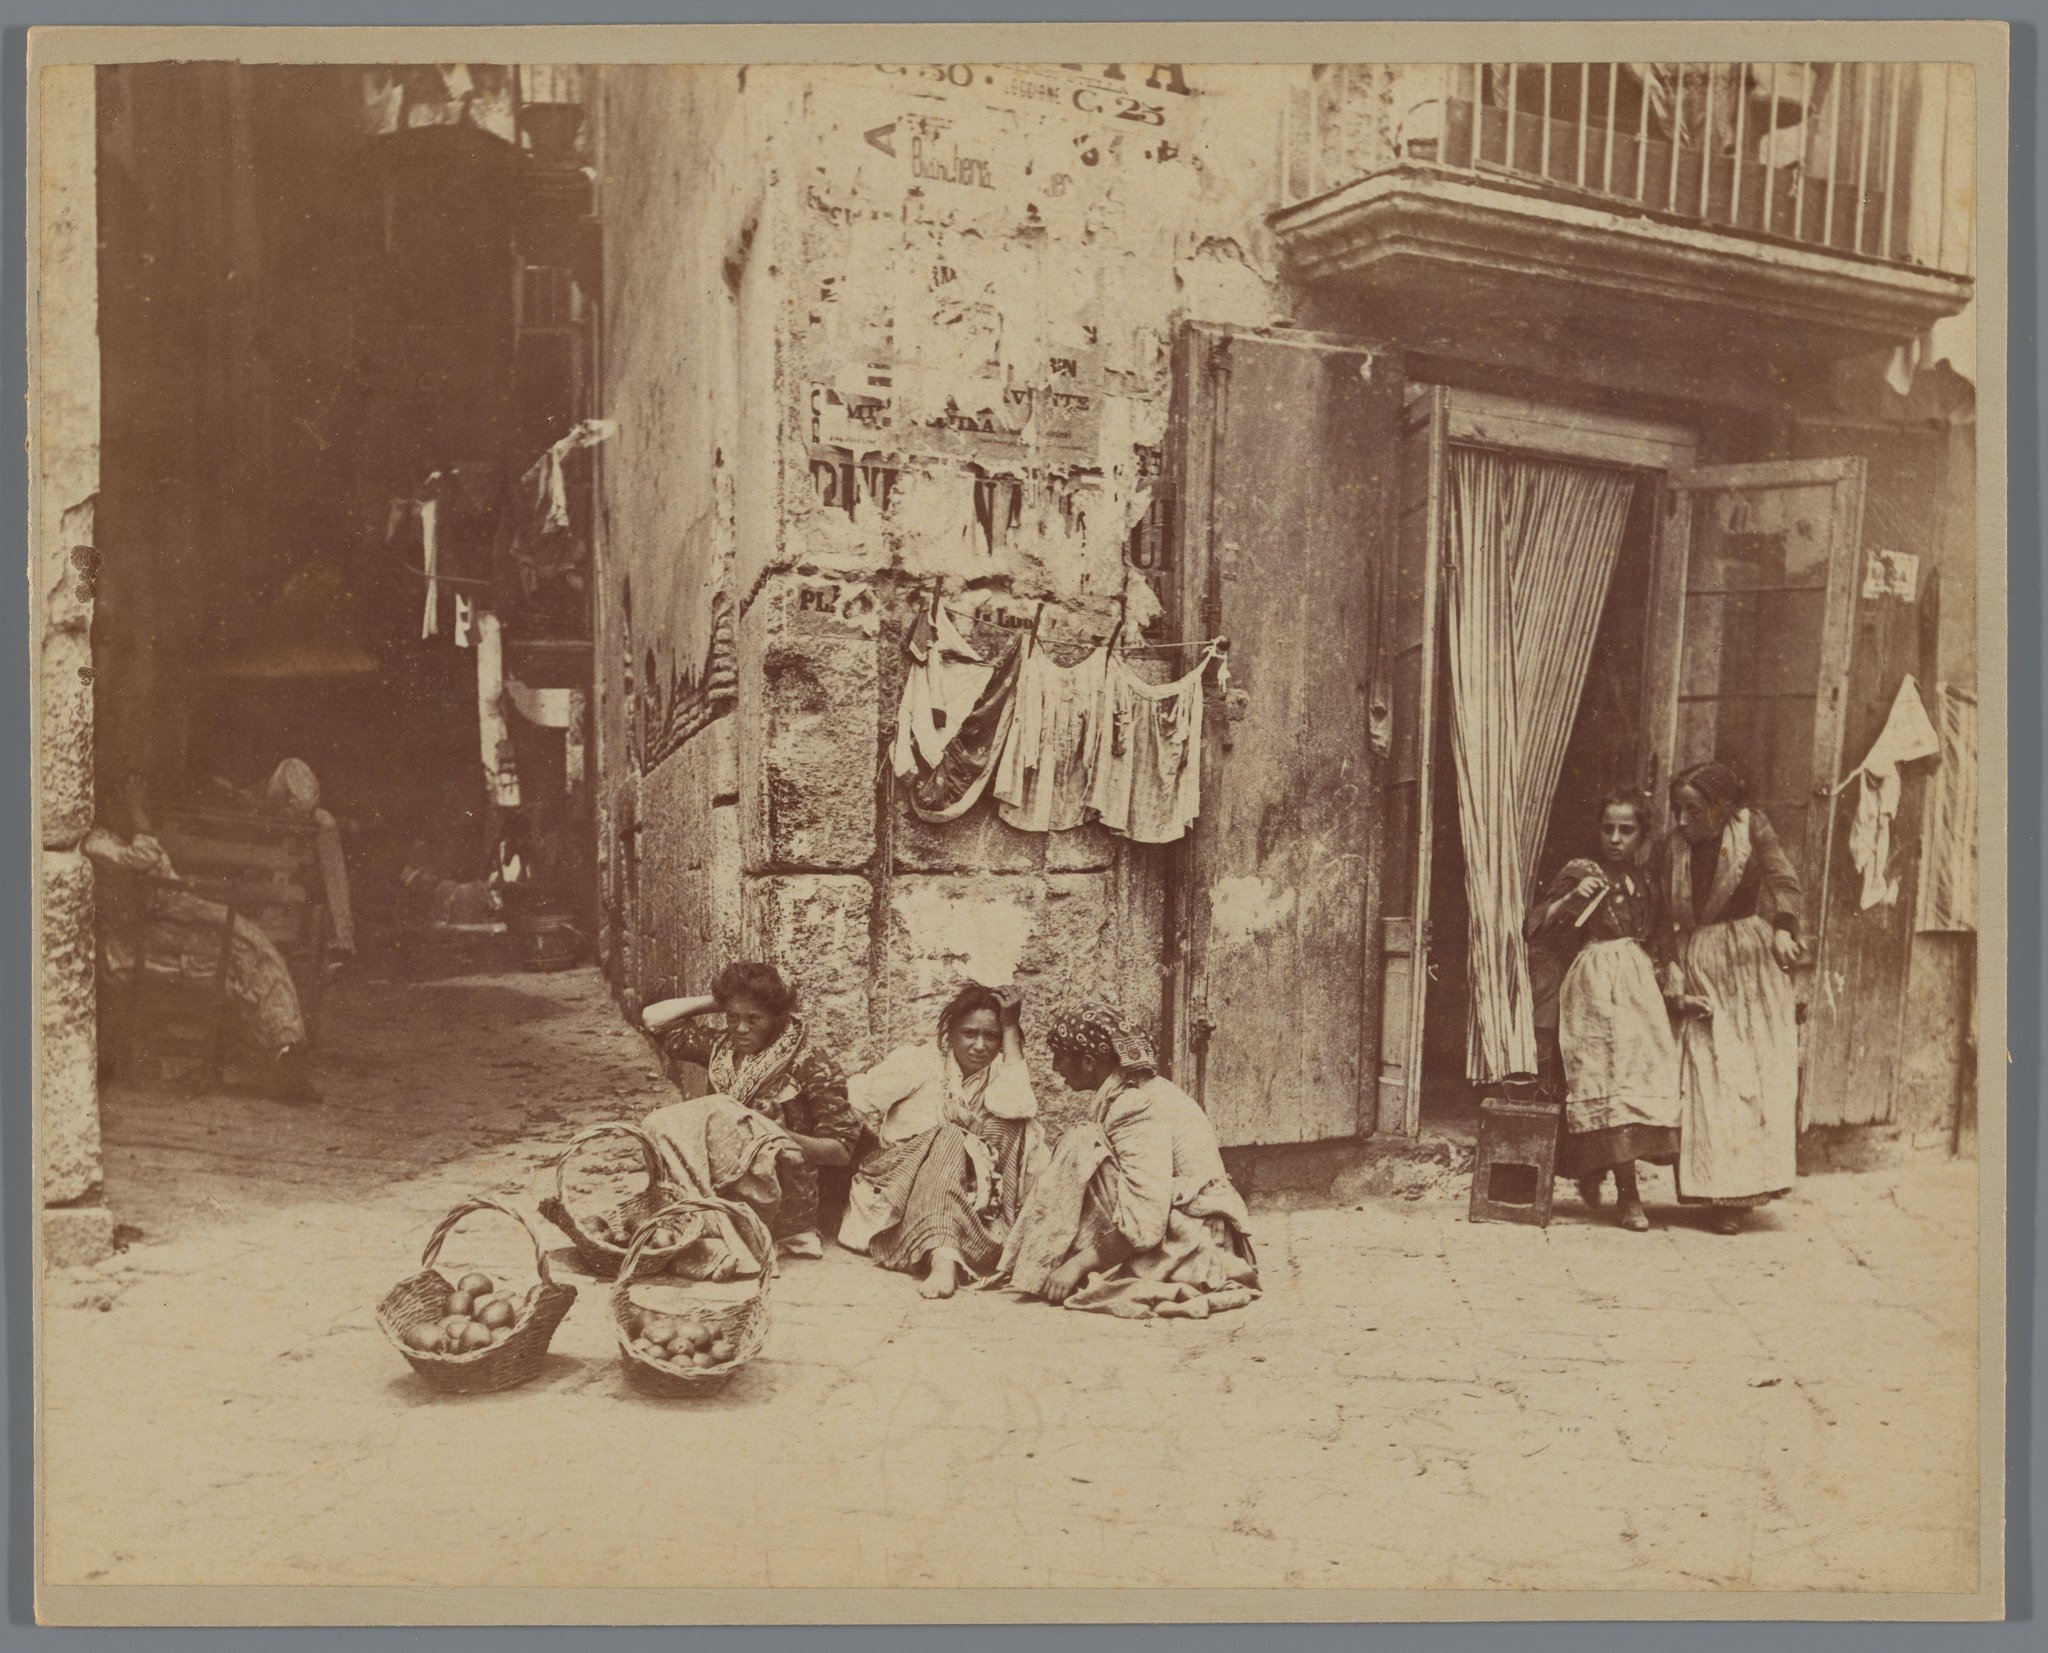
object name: photograph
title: Fruitverkopers op straat, mogelijk in Noord-Afrika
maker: Anonymous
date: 1870-1890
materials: cardboard, paper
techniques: albumen print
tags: street, fruits